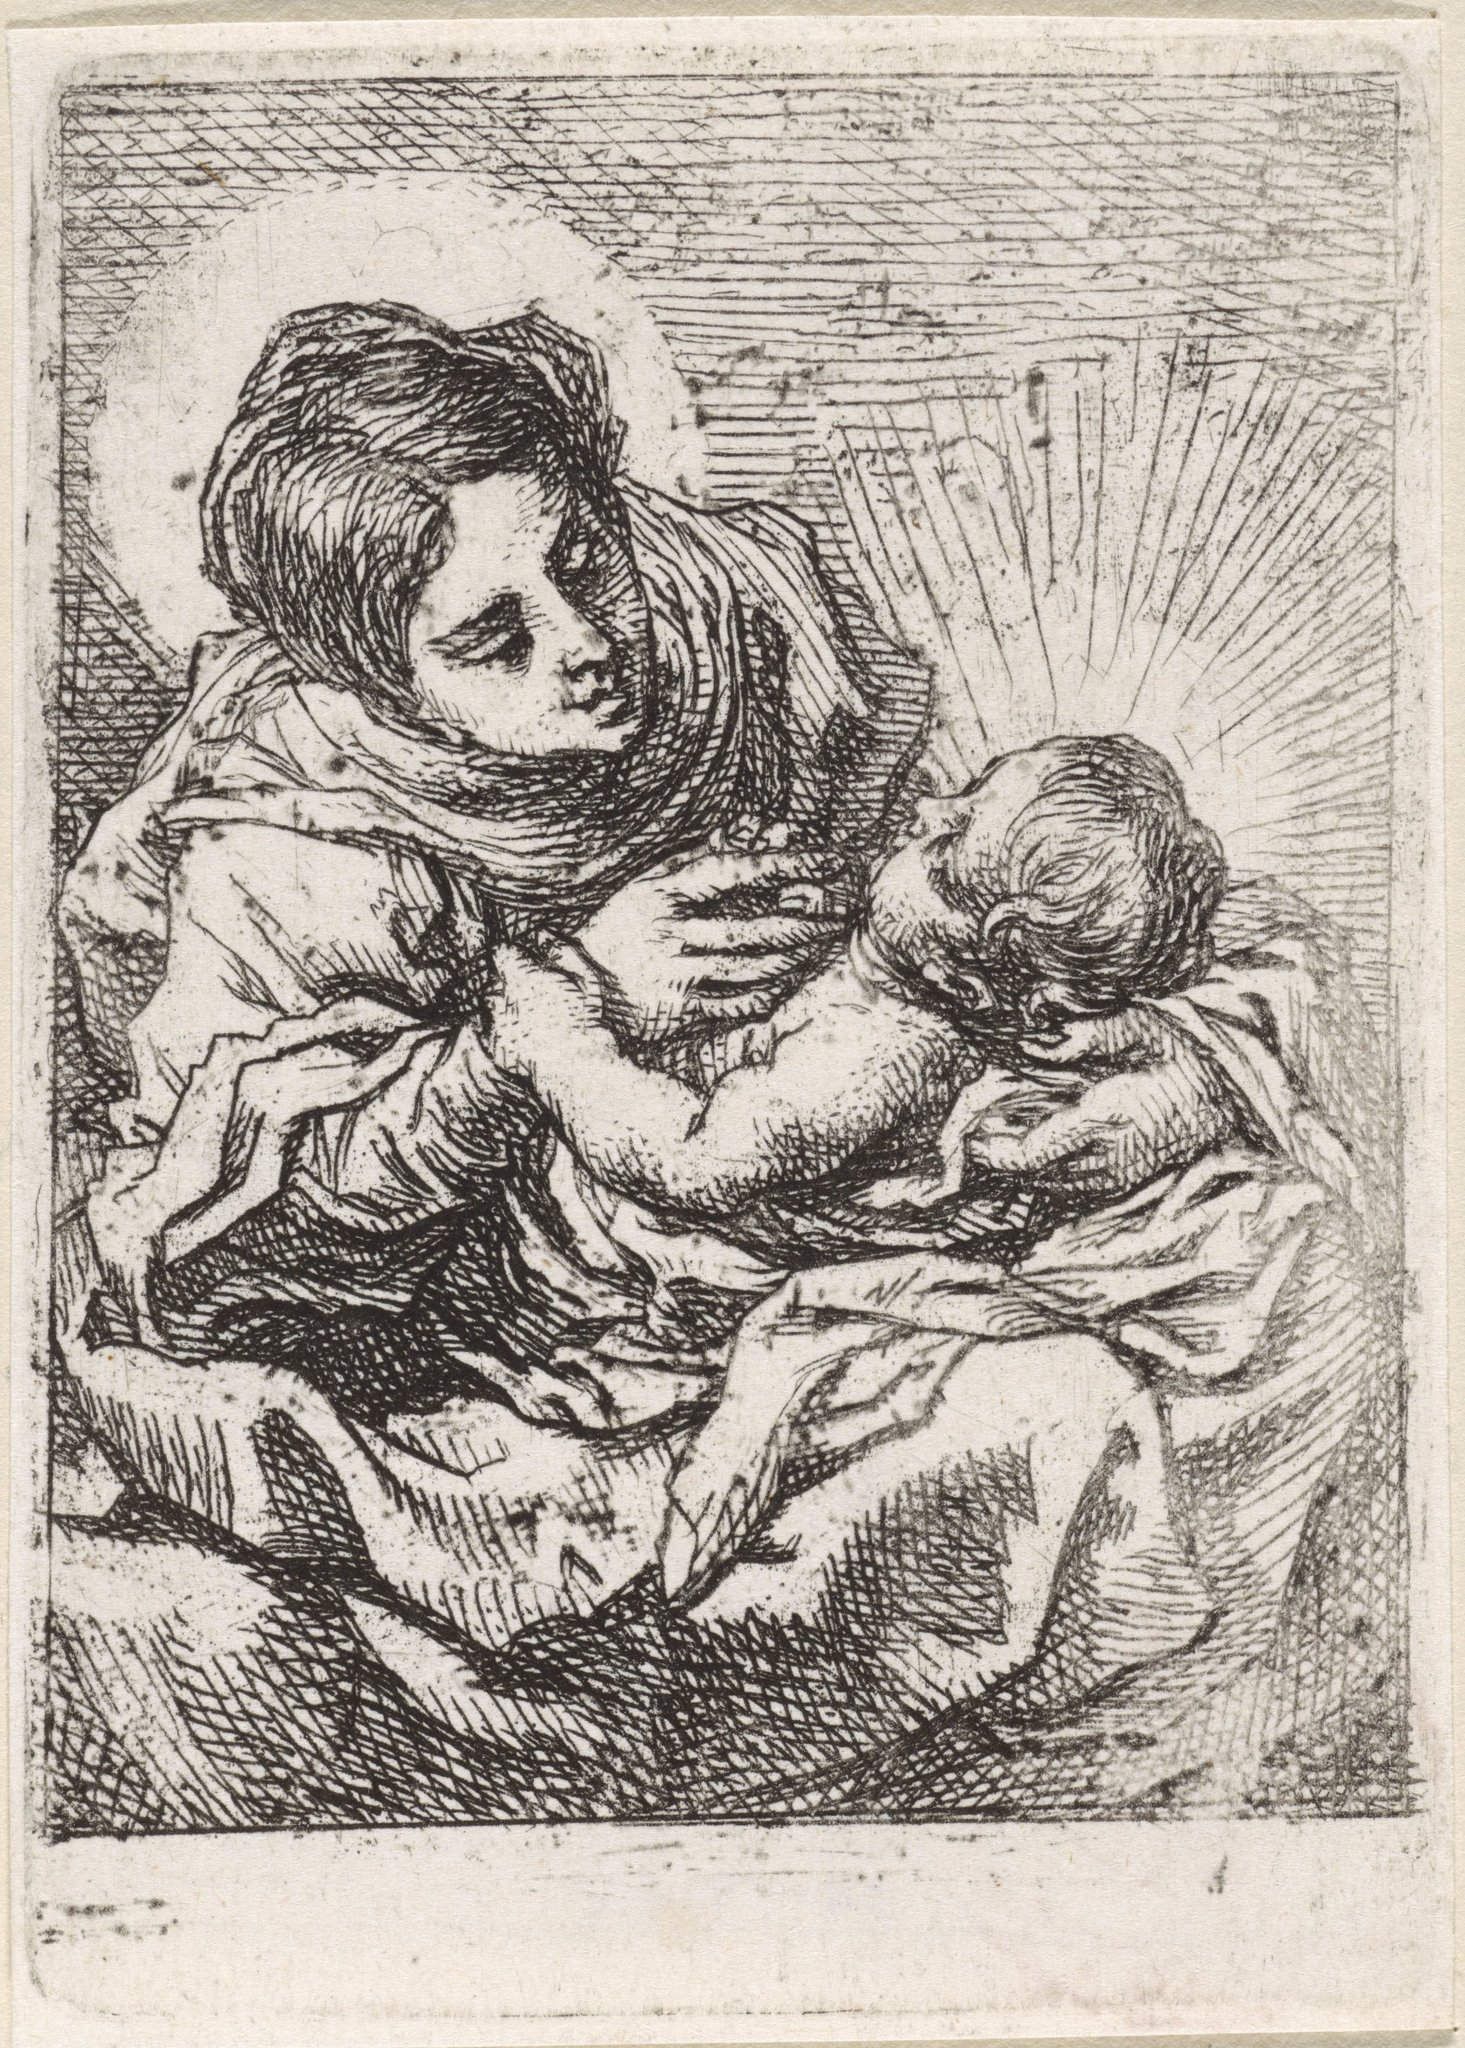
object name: print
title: Madonna met kind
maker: cornelis schut (i)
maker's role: draughtsman, print maker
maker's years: 1597-1655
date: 1618-1655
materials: paper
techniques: etching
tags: madonna: mary sitting or enthroned, the christ-child in her lap (or in front of her bosom) (mary sometimes represented half-length)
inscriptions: collector's mark: Lugt 240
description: Maria buigt zich over het Christuskind op haar schoot. Het Christuskind houdt haar hand met beide handen vast.